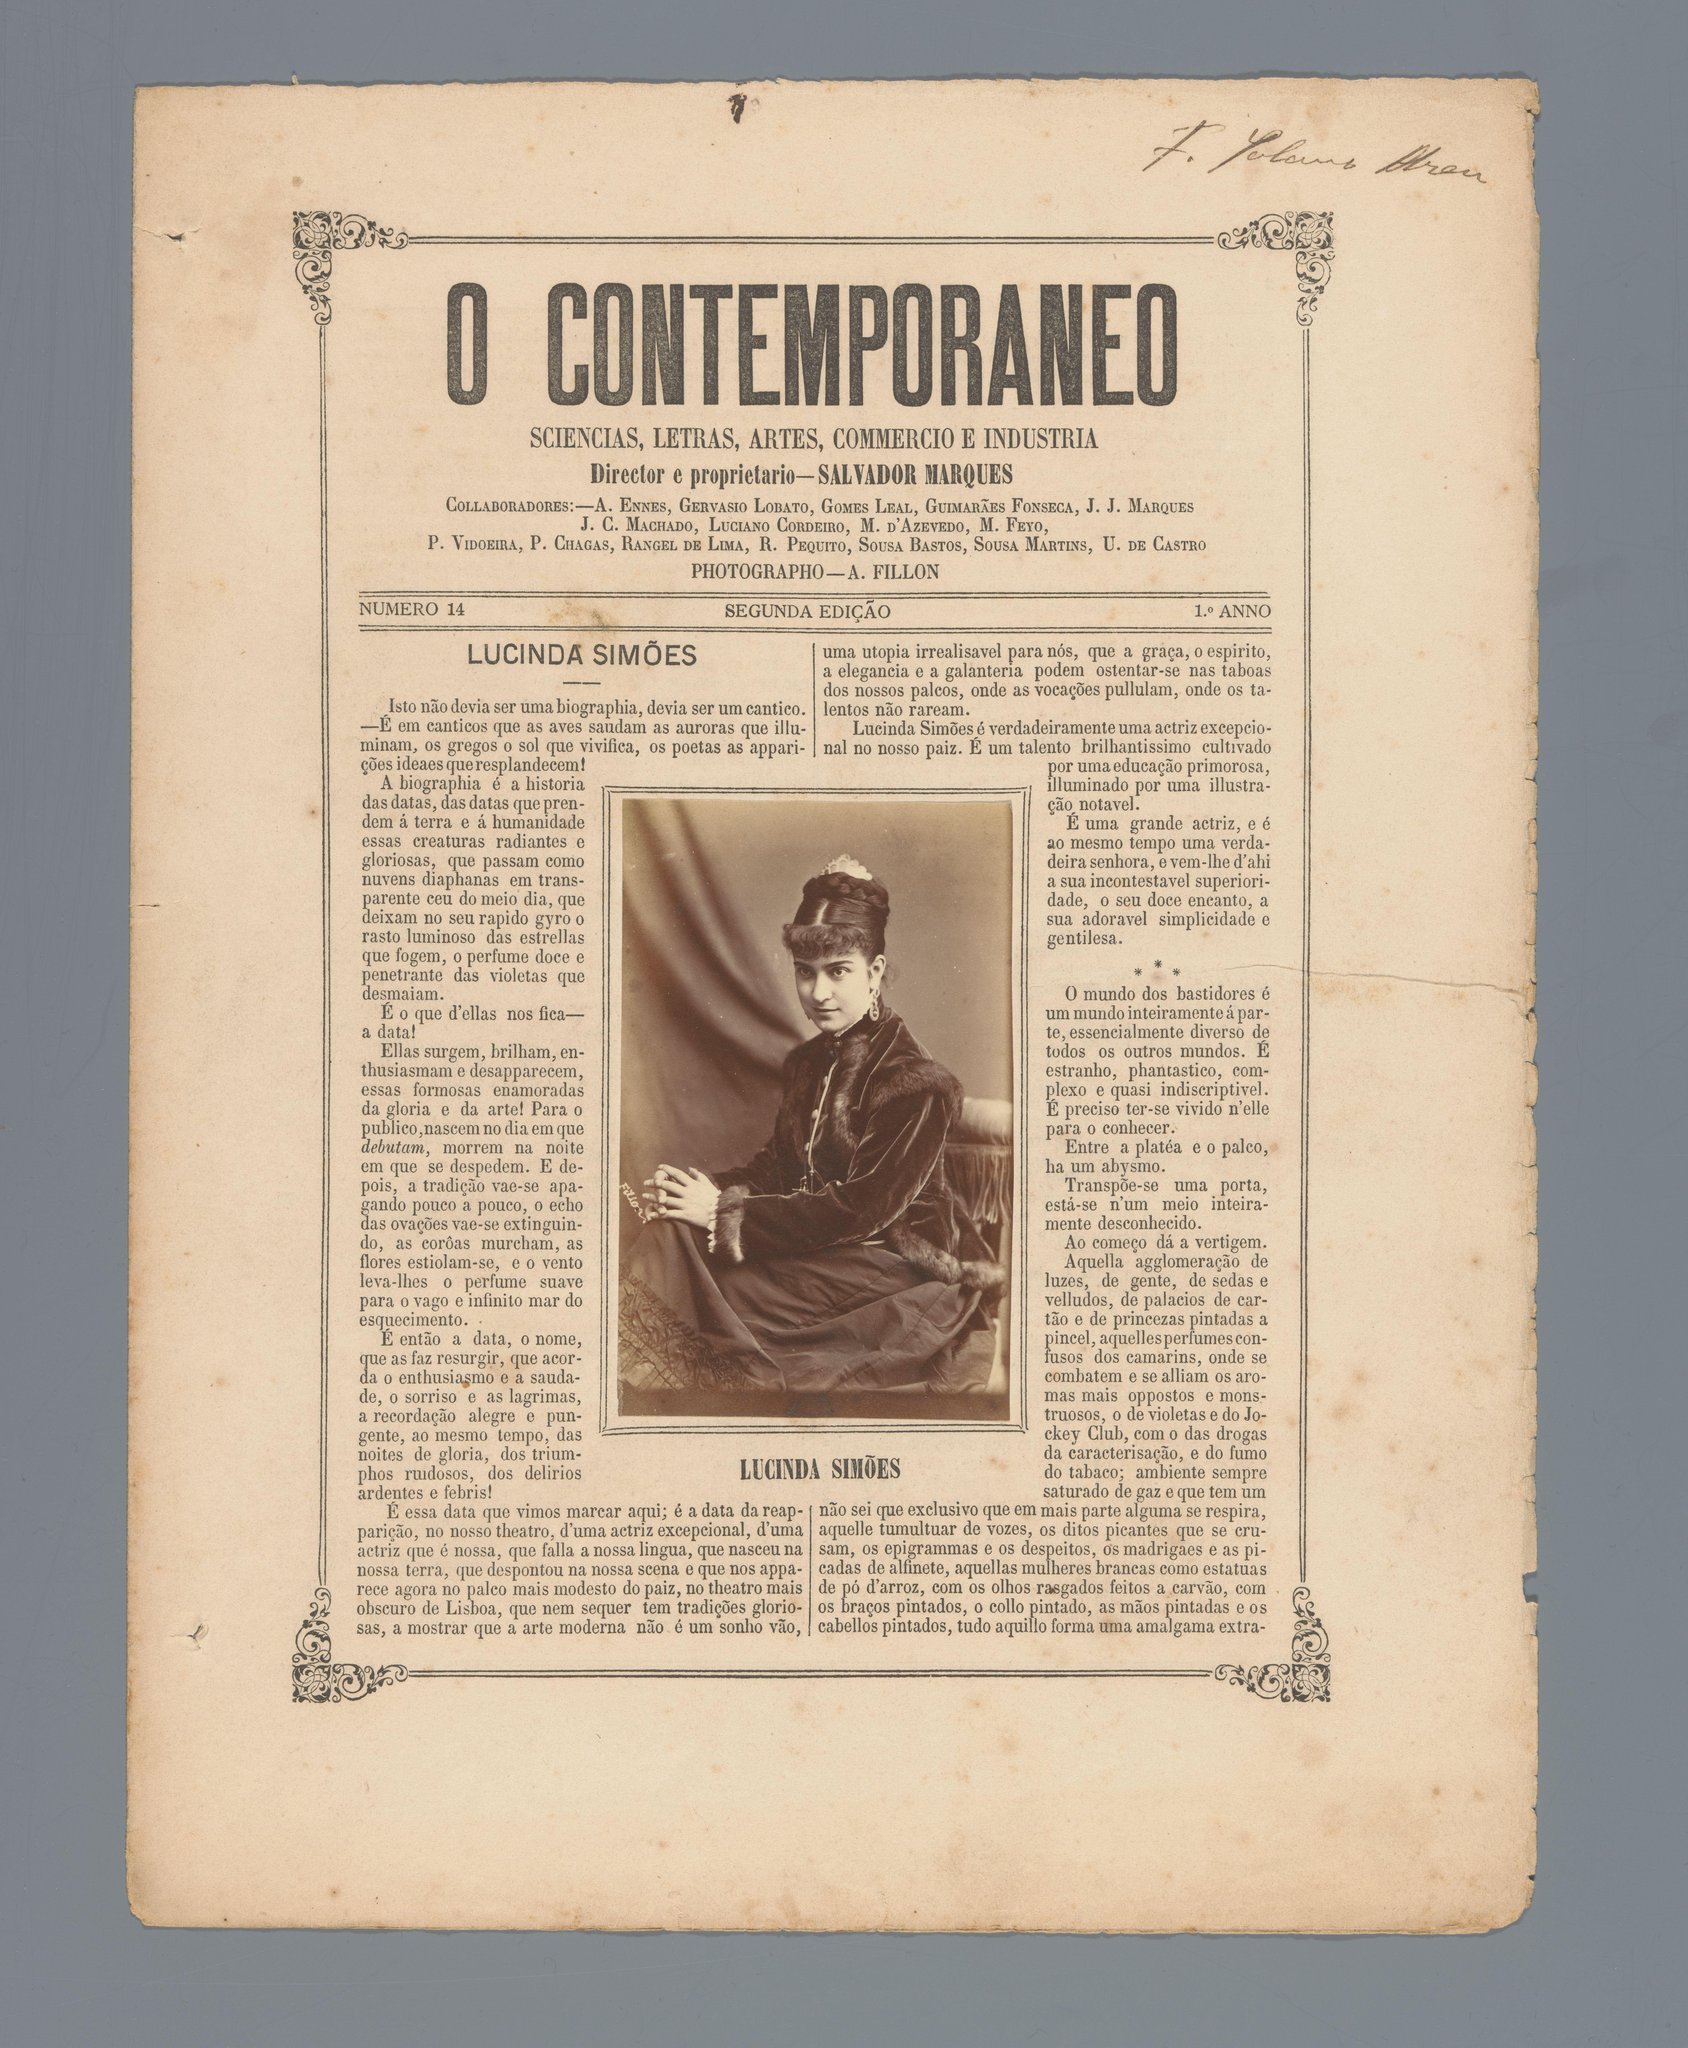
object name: photograph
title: O contemporaneo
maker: alfred fillon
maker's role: fotograaf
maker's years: 1825-1881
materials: paper, photographic support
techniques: albumen print, printing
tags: historical persons - bb - woman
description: Op de voorpagina bevindt zich een portret van Lucinda Simões.